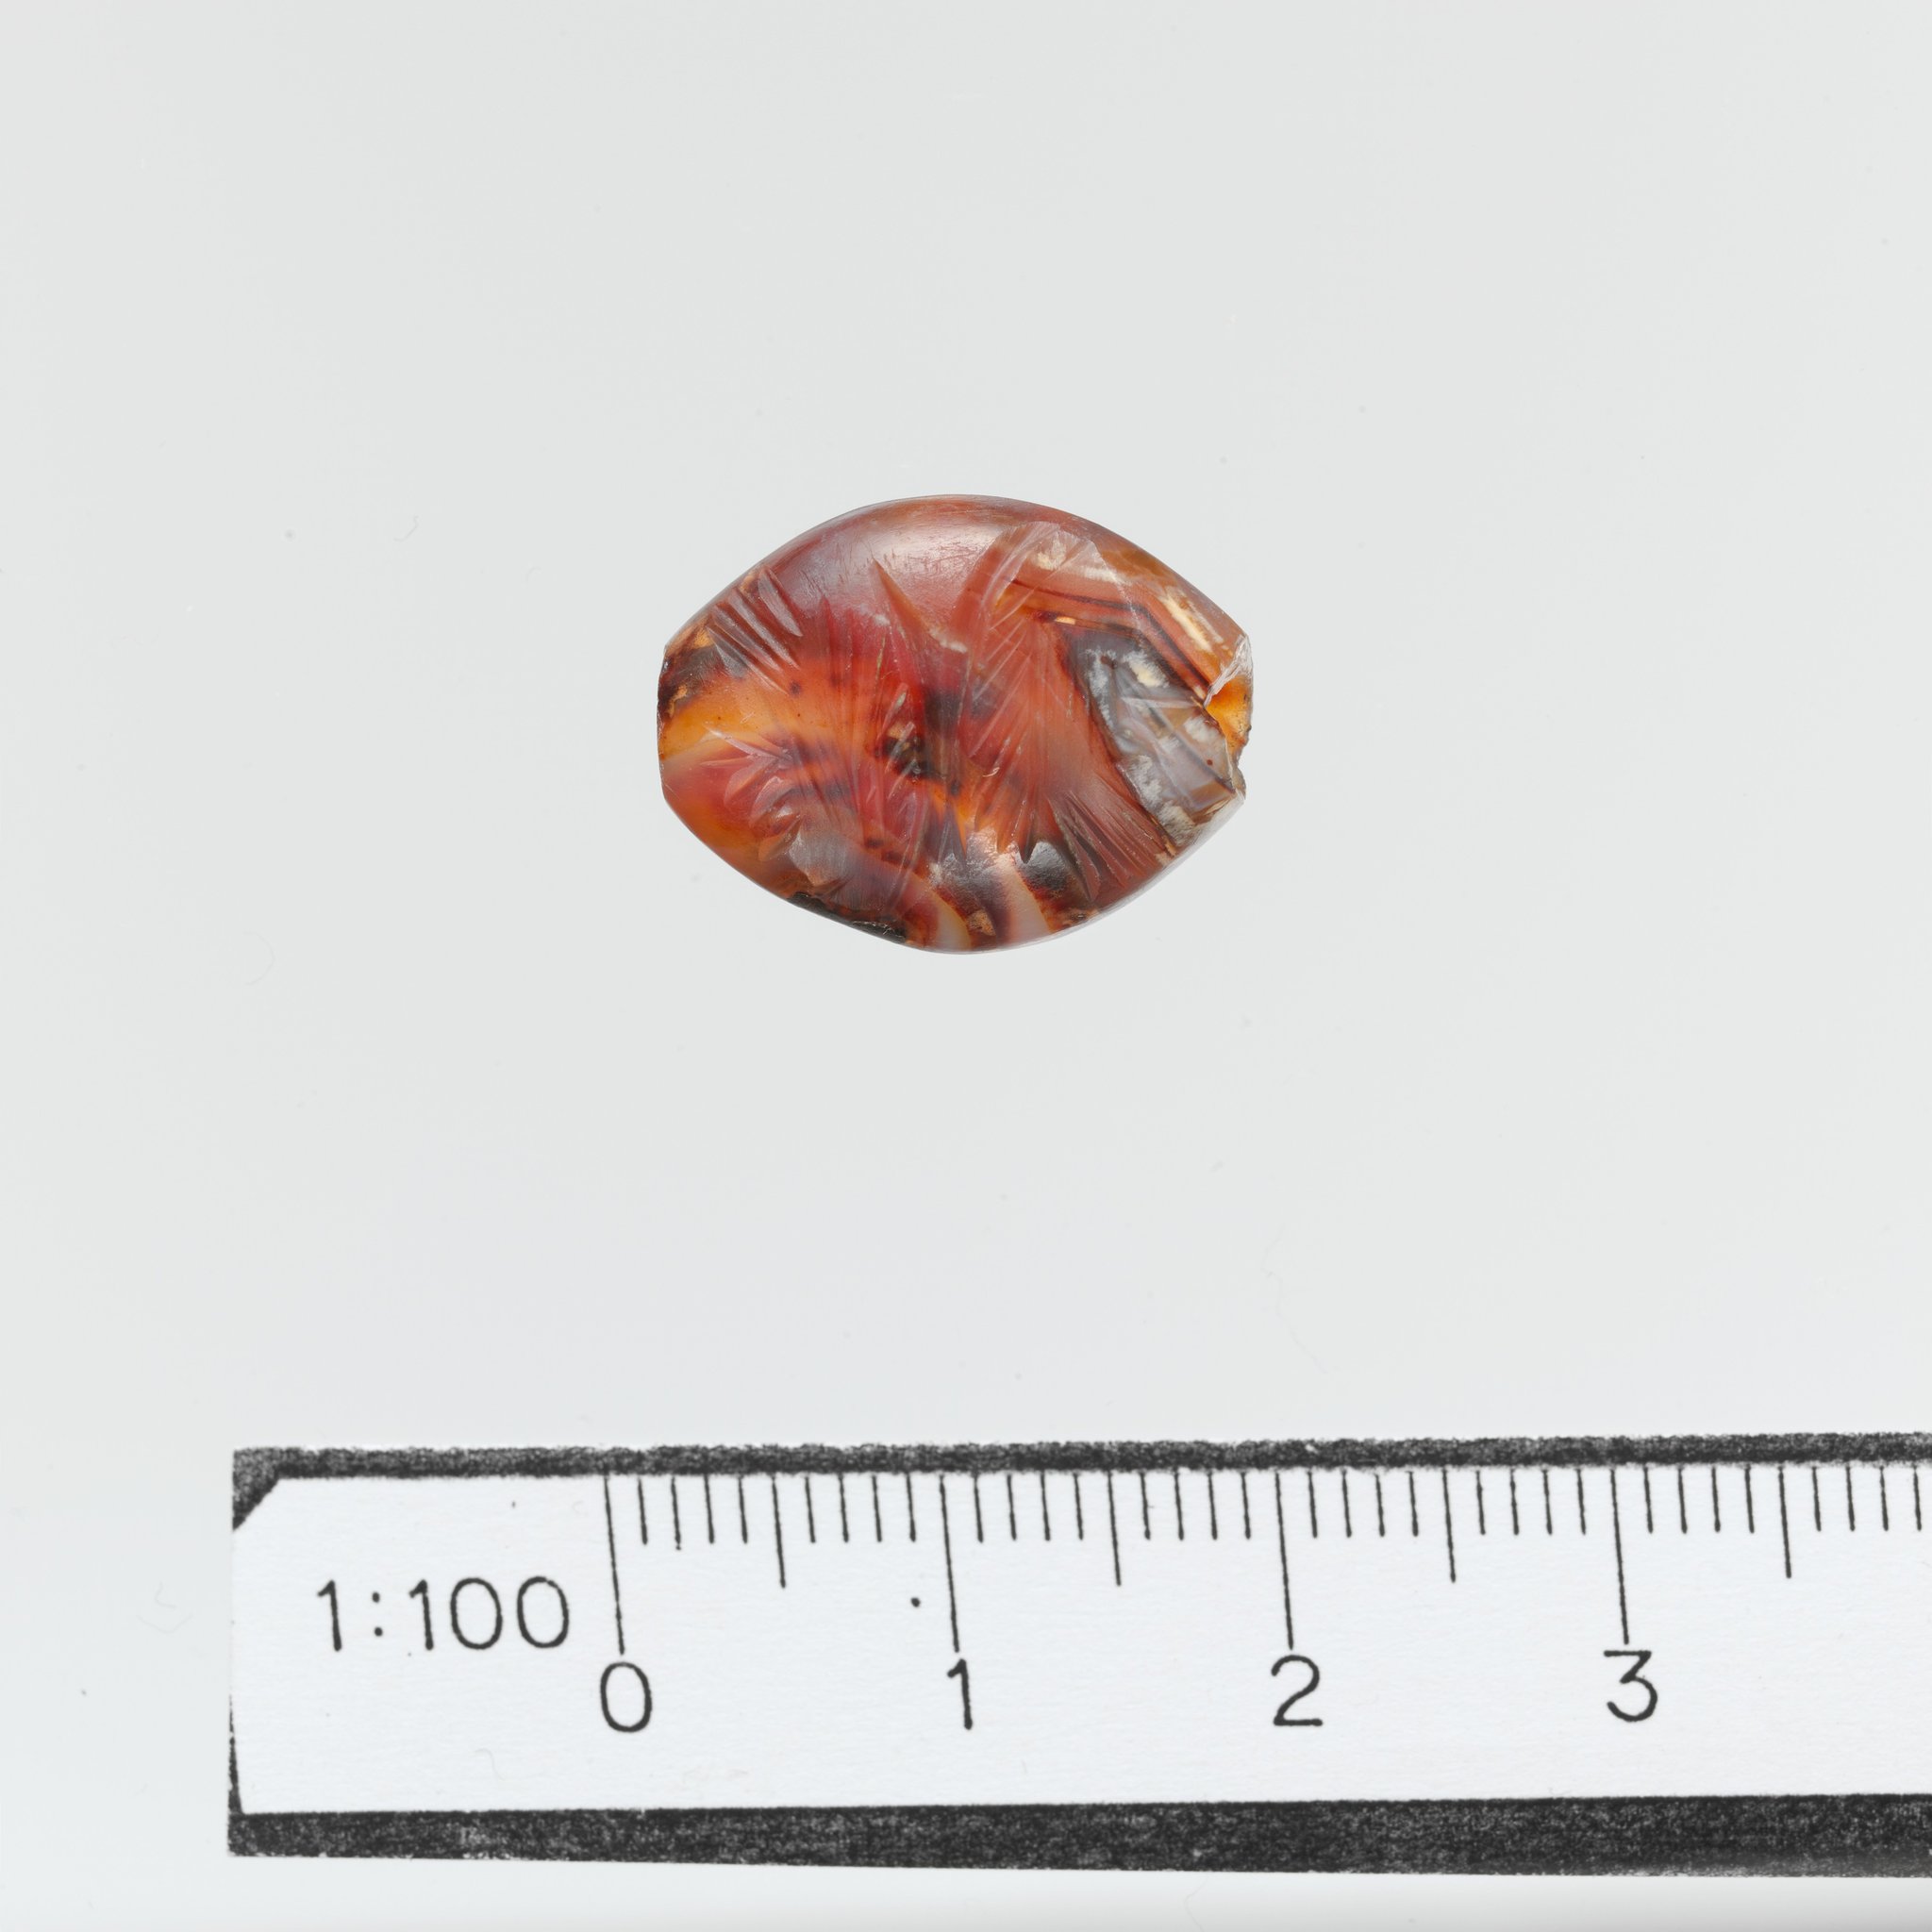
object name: seal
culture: minoan, crete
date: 2000-1450 BCE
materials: stone, gemstone